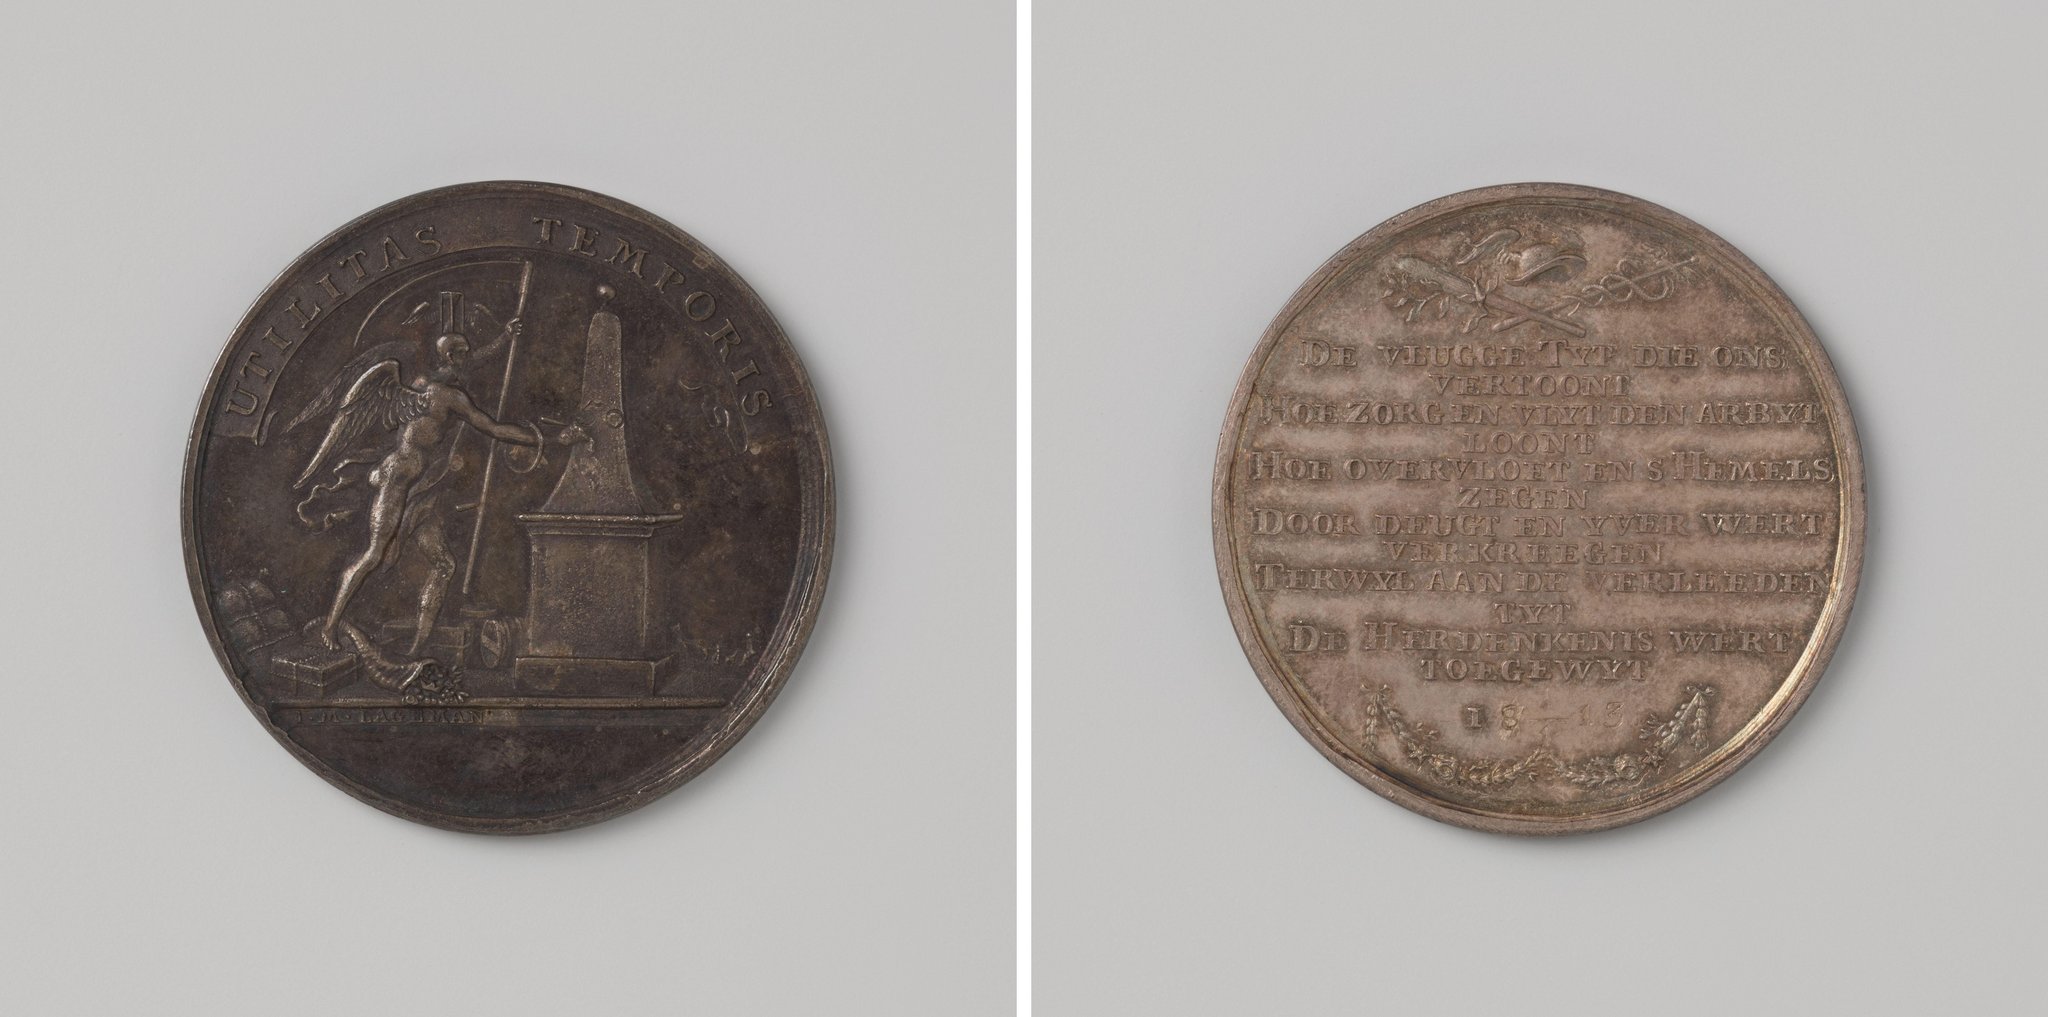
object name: history medal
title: Vijftigjarig jubileum als rekenmeester van Jacob Cuyk van Mierop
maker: johannes michiel lageman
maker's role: silversmith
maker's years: 1735-1809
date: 1813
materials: silver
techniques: engraving, striking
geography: amsterdam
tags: amsterdam